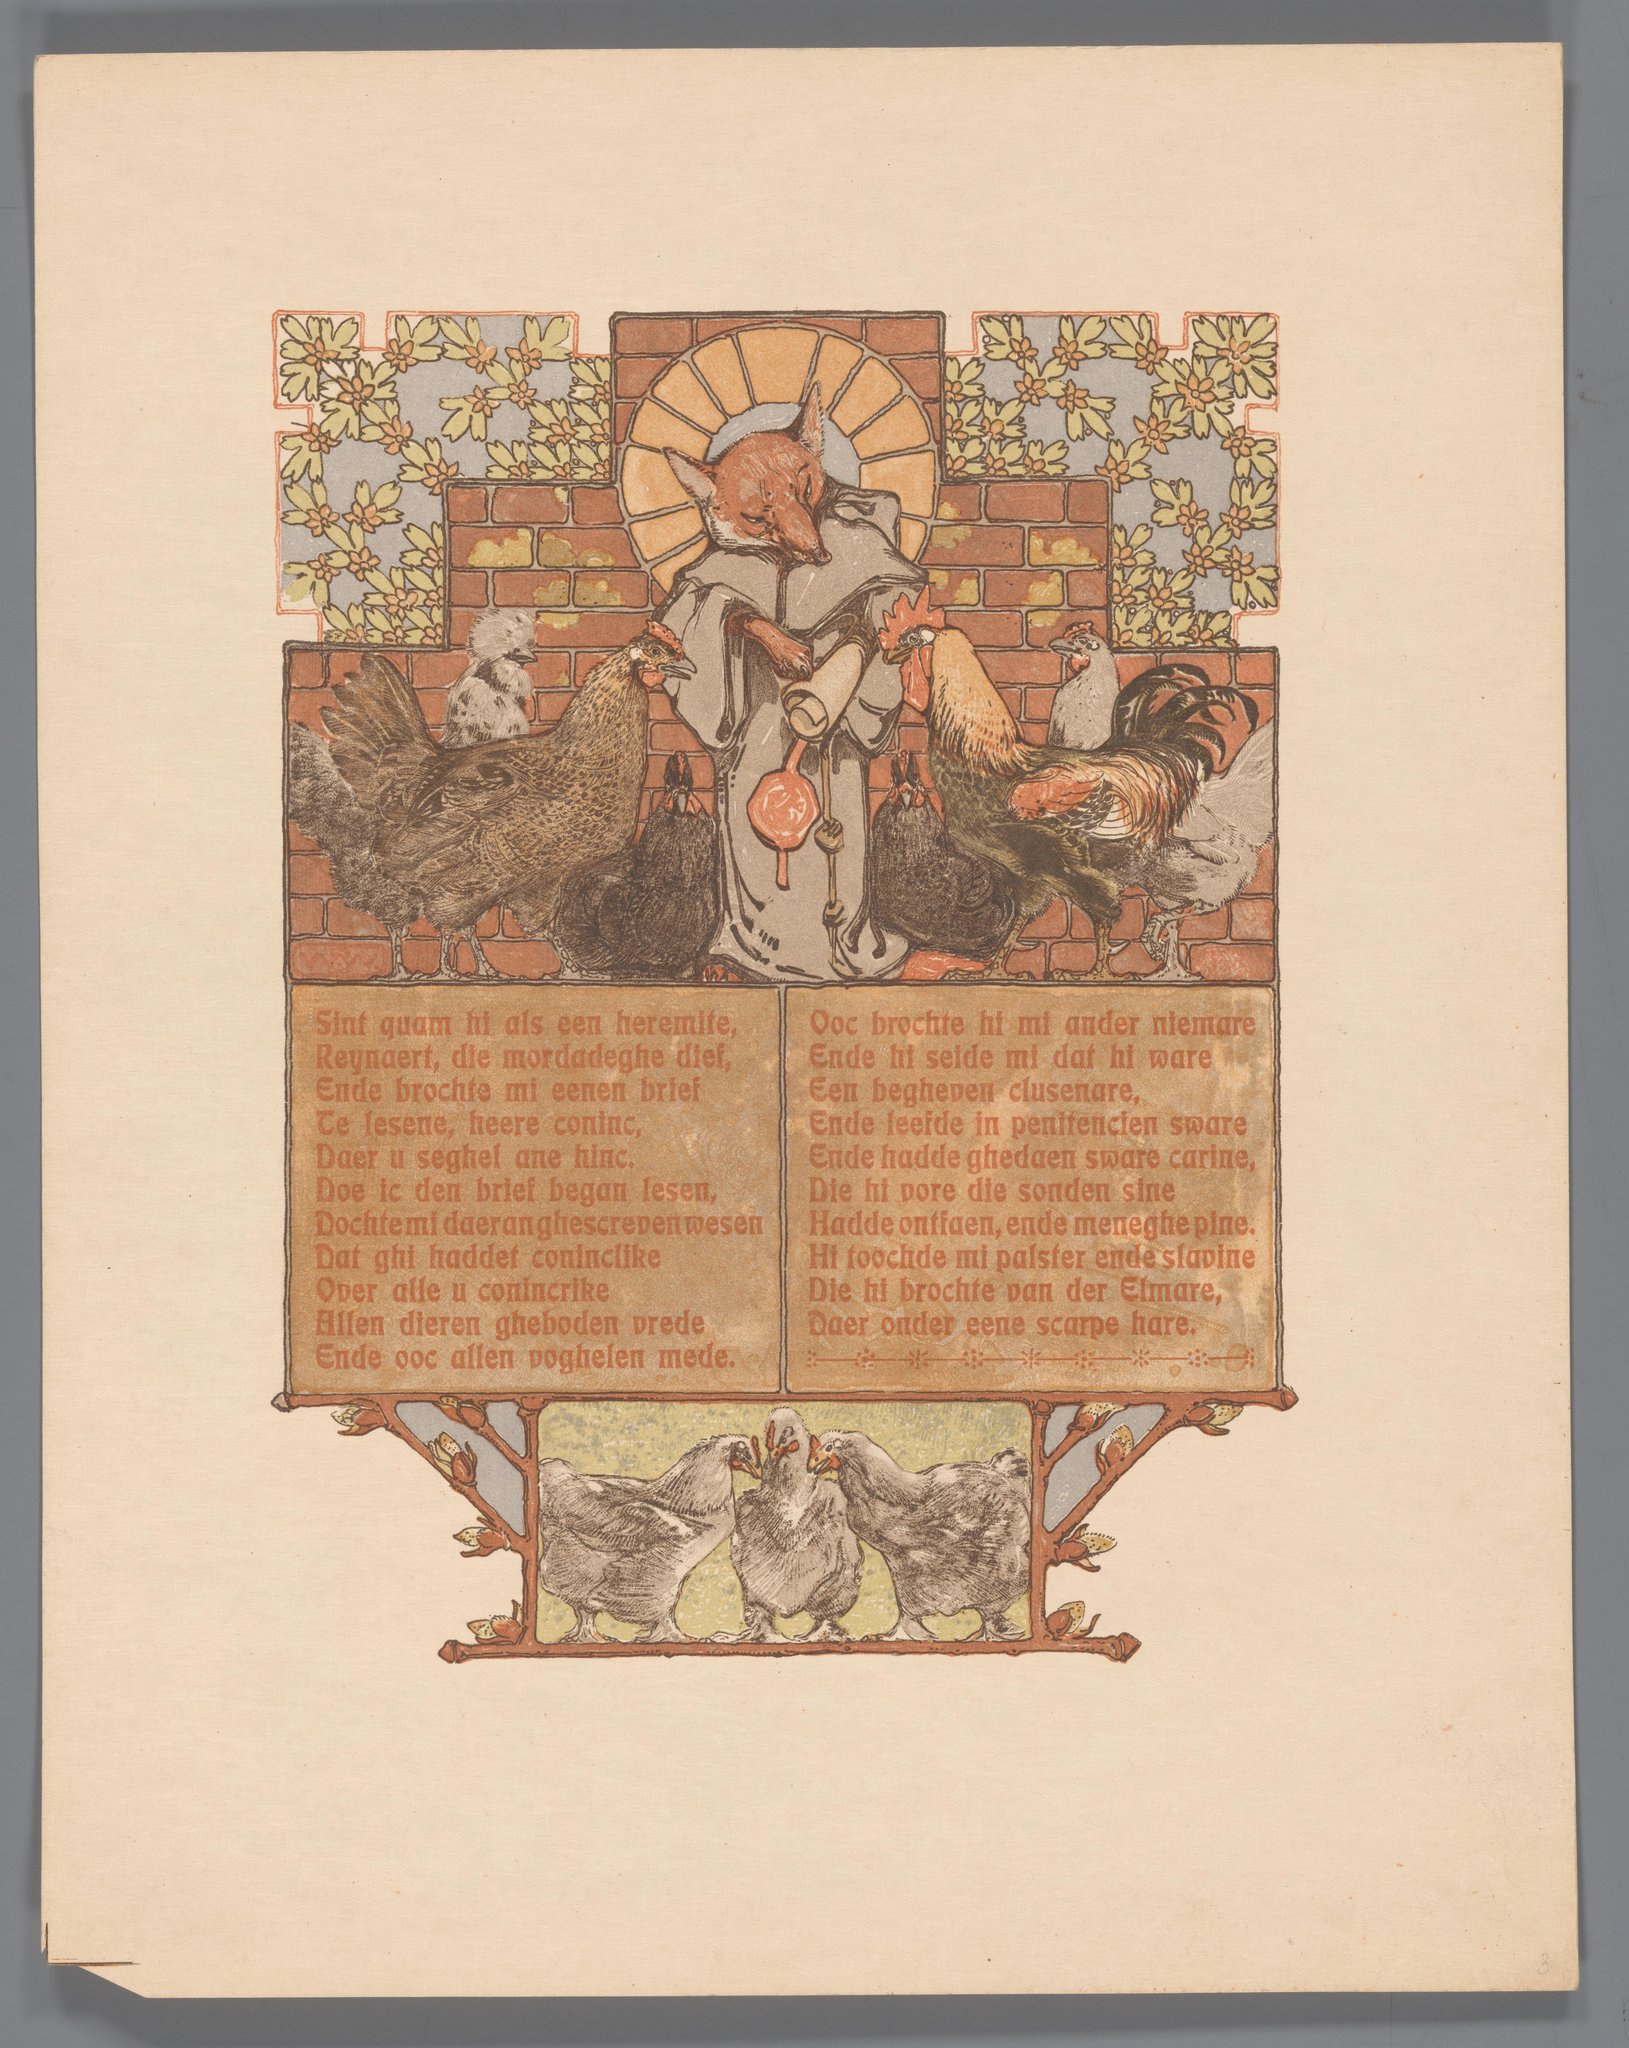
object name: print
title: Vos in monnikspij (Reinaert) omringd door kippen en haan (Cantecleer)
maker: bernard willem wierink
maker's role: draughtsman, print maker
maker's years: 1856-1939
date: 1910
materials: paper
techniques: lithograph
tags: fable of reynard the fox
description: Prent gebruikt in: Streuvels, Stijn (Frank Lateur). Reinaert de Vos naar verschillende uitgaven van het middeleeuwsche epos. Amsterdam: L.J. Veen, 1910.